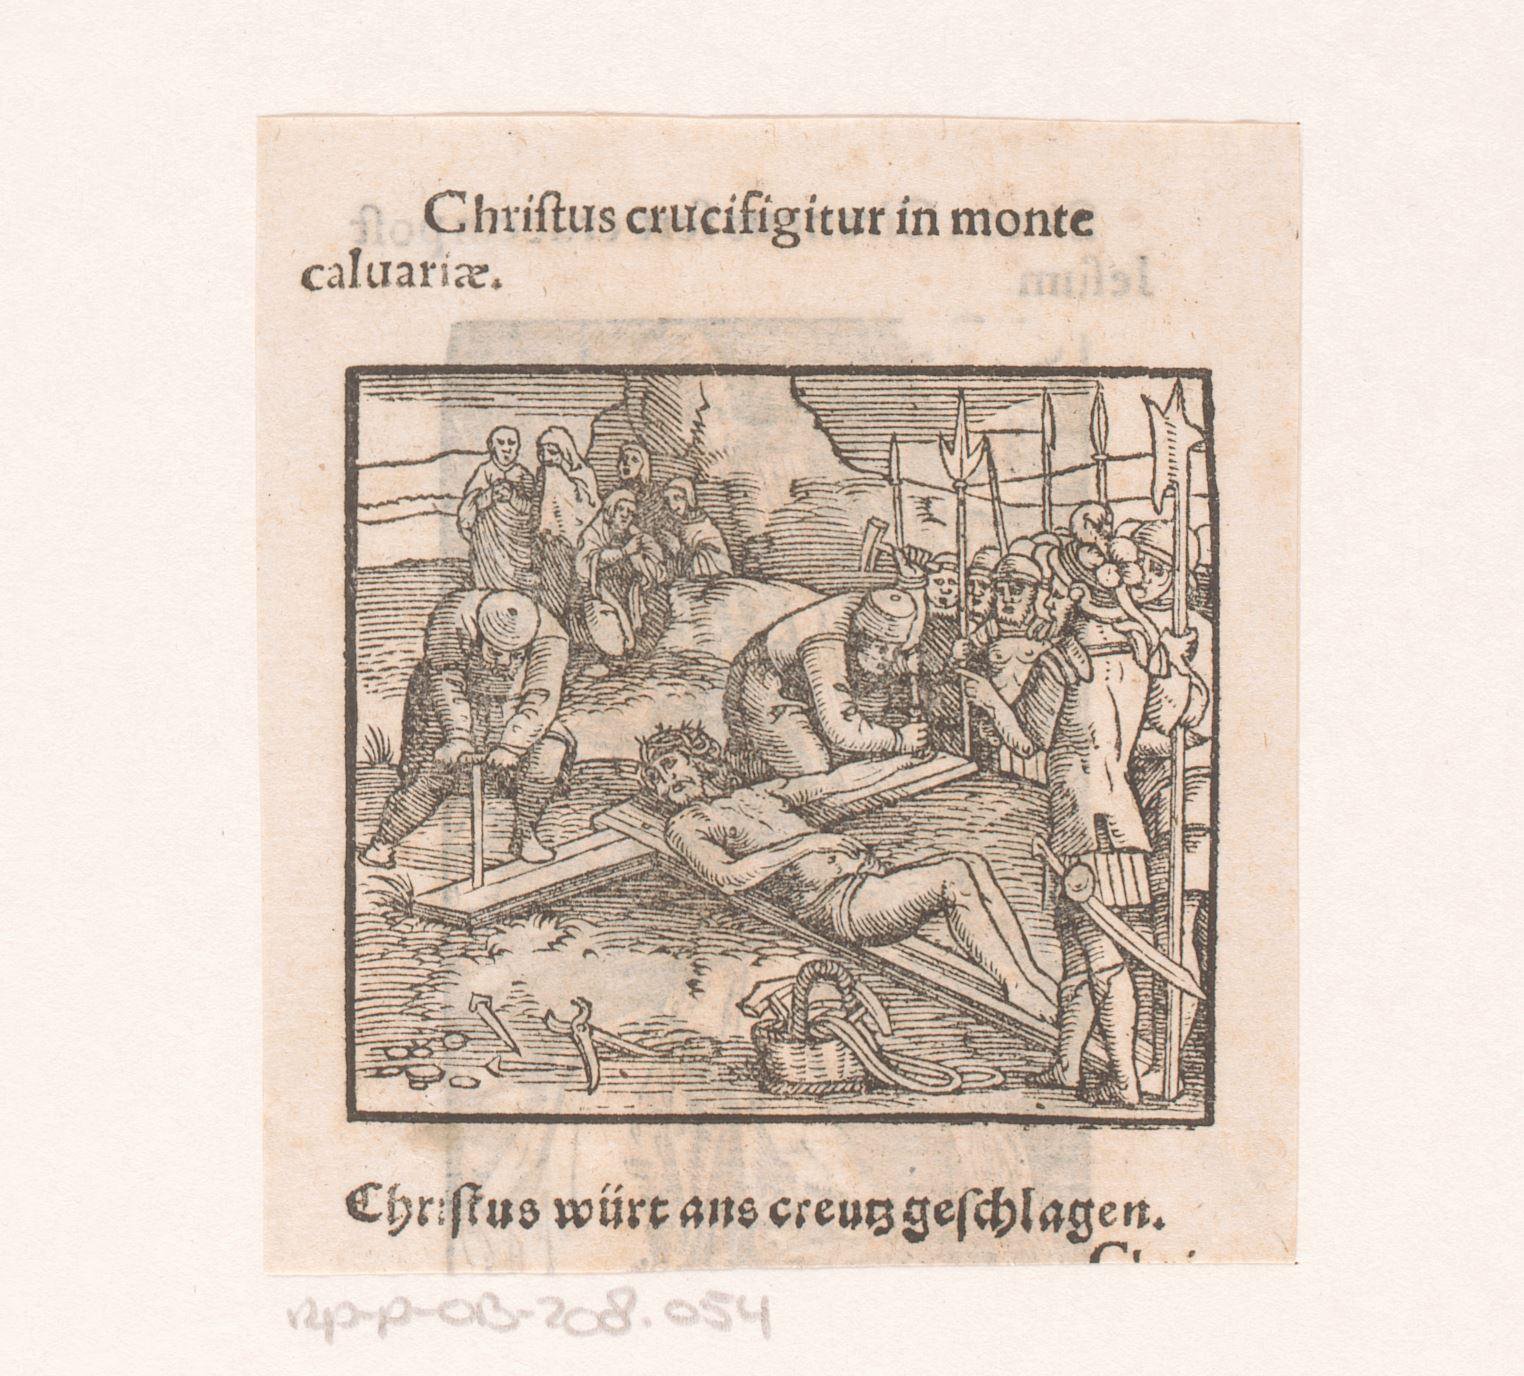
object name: print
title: Kruisiging van Christus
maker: Anonymous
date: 1600-1699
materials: paper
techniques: letterpress printing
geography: netherlands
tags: the erection of the cross: christ is nailed to the cross which lies on the ground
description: Het kruis ligt op de grond. Een aantal mannen nagelt Christus vast aan handen en voeten.